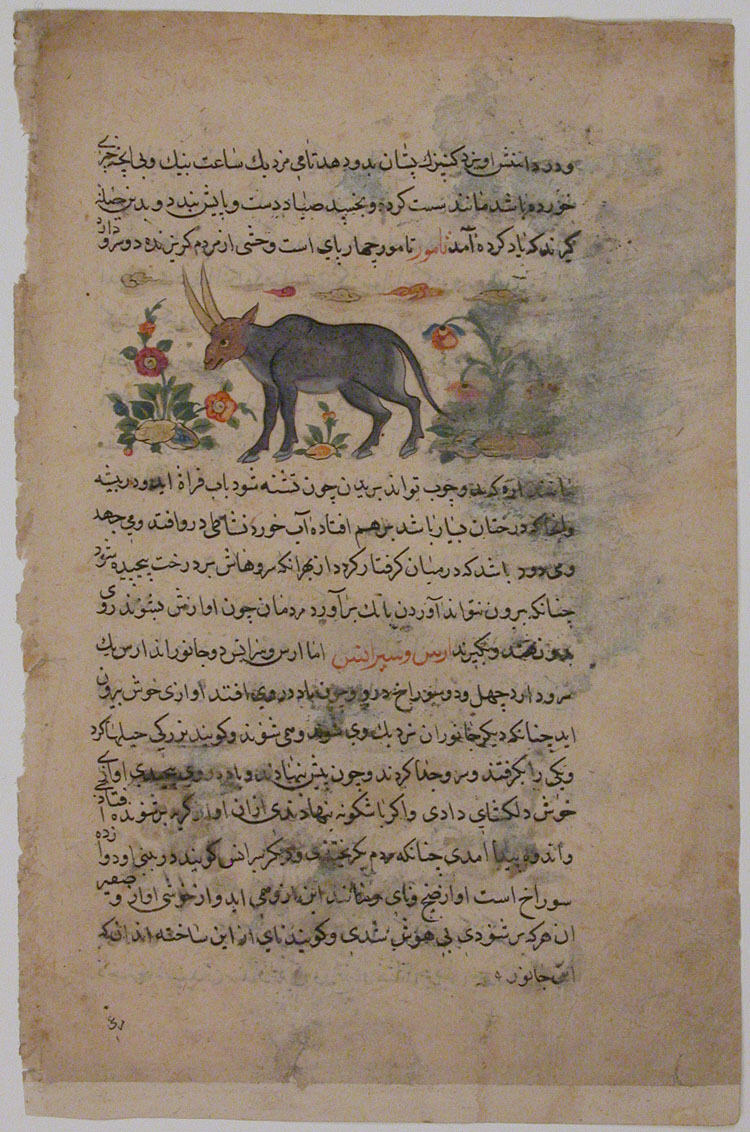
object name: folio from an illustrated manuscript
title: "Steinbok", Folio from a Dispersed Nuzhatnama-i ‘A’a’i of Shahmardan ibn Abi’l Khayr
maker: shamardan ibn abi 'l khayr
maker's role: author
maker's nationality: iranian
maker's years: 1075-1125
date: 1467-1533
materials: gold, ink, paper, watercolor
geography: iran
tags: animals,flowers,leaves